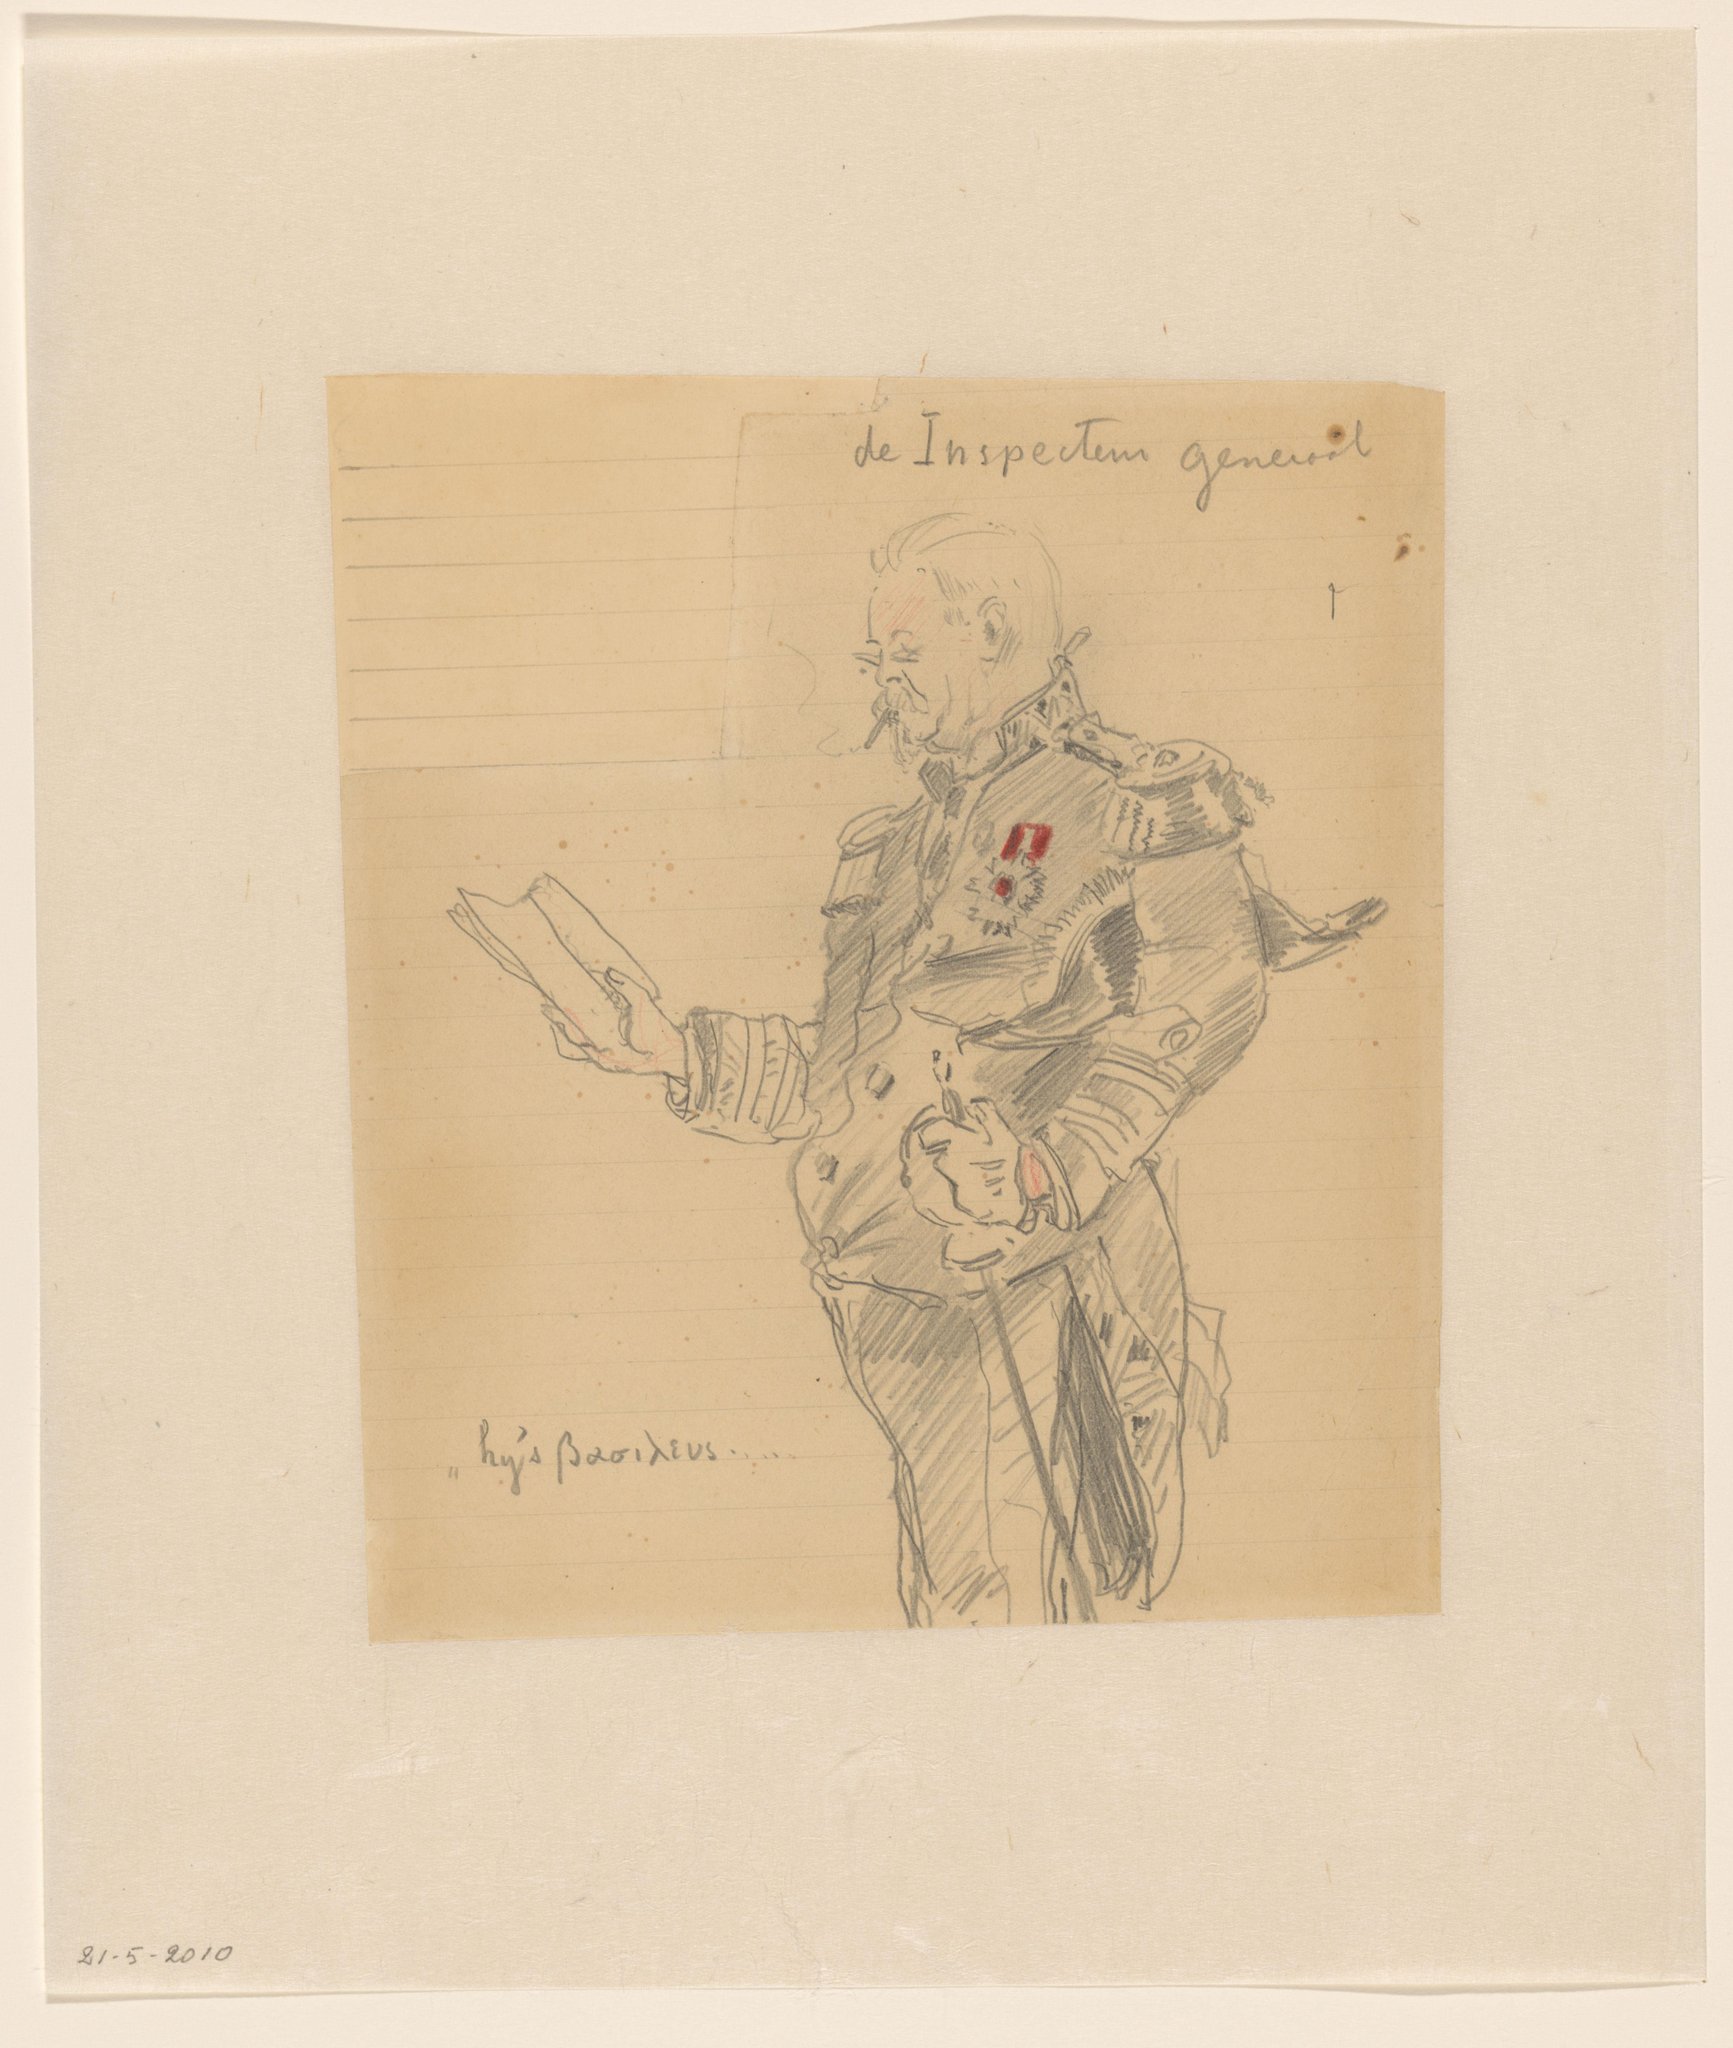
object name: drawing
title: De Inspecteur Generaal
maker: willem vogelsang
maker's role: draughtsman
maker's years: 1875-1954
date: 1921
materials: chalk, paper, pencil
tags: the hague, cornelis hofstede de groot, caricatures (human types), historical persons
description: Karikatuur of het denkbeeld van Dr. C. Hofstede de Groot om dit ambt bij de musea in te voeren, 1921